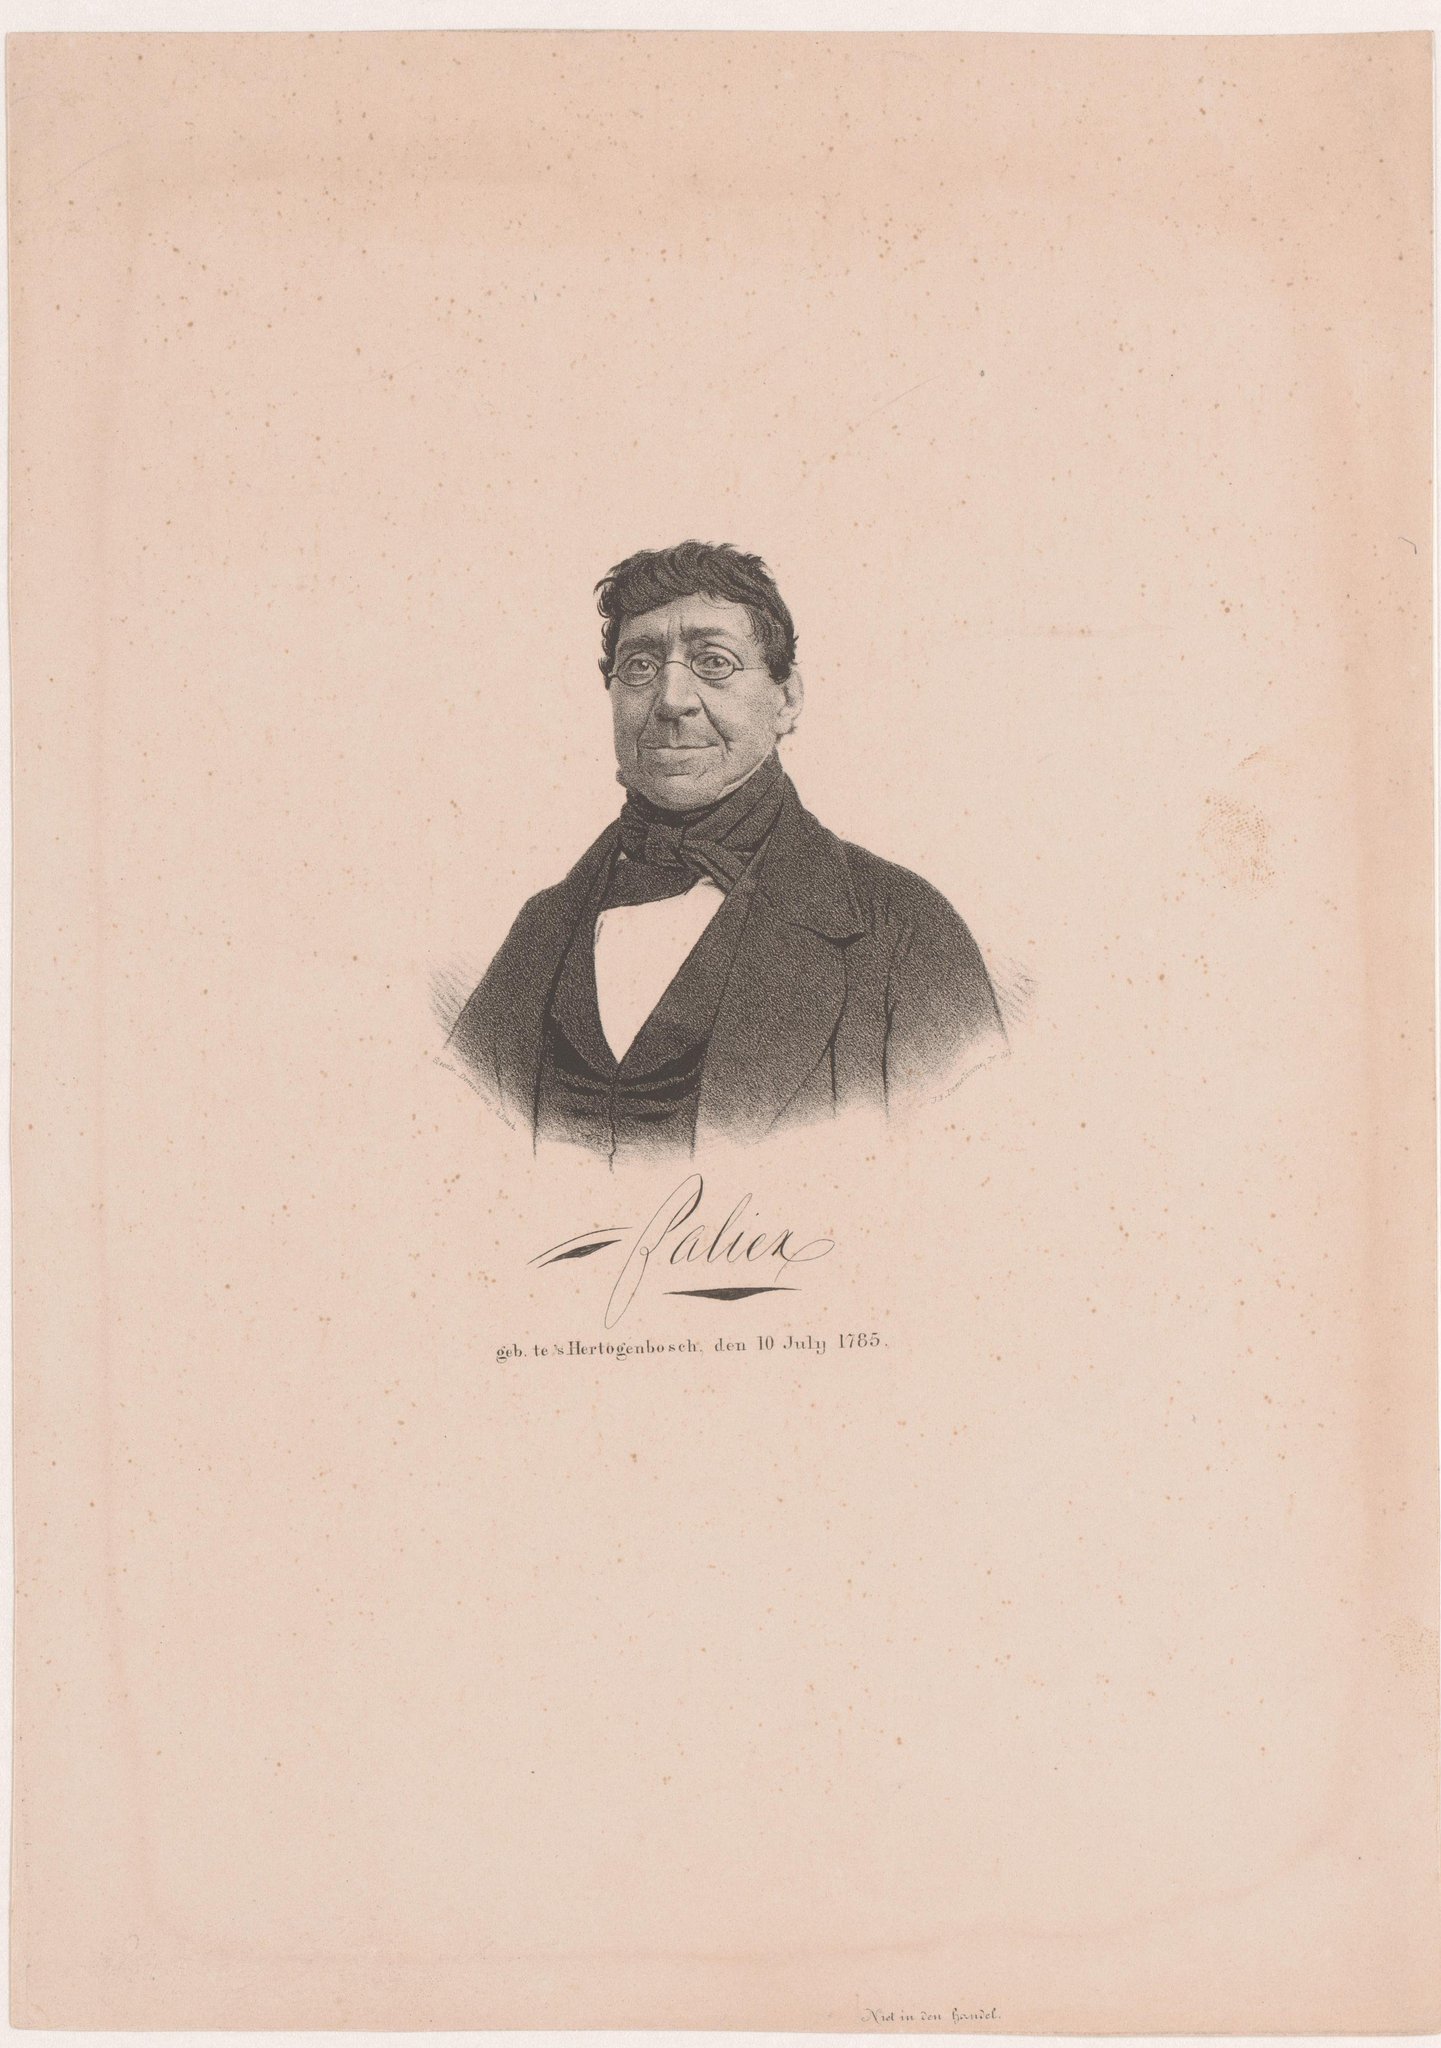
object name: print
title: Portret van Hendrik Palier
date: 1836-1861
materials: paper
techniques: lithograph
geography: den bosch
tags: hendrik palier, eyeglasses, spectacles, historical persons (+ (full) bust portrait)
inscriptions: collector's mark: Lugt 2228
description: De geportretteerde draagt een gestrikte das en een bril. Onder het portret zijn signatuur.